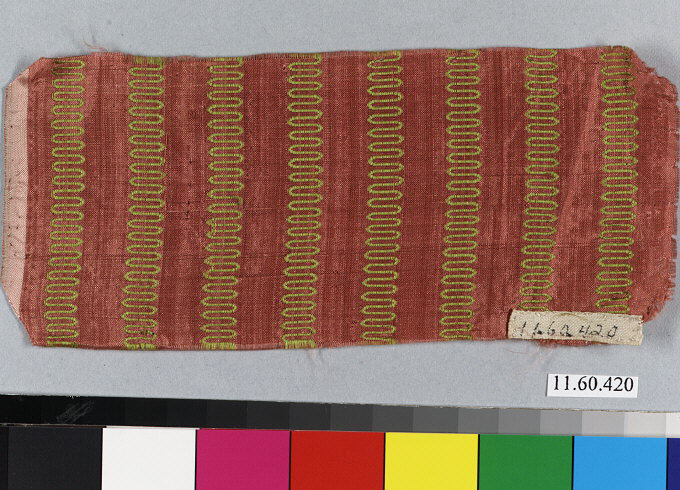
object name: fragment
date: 1801-1900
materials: silk